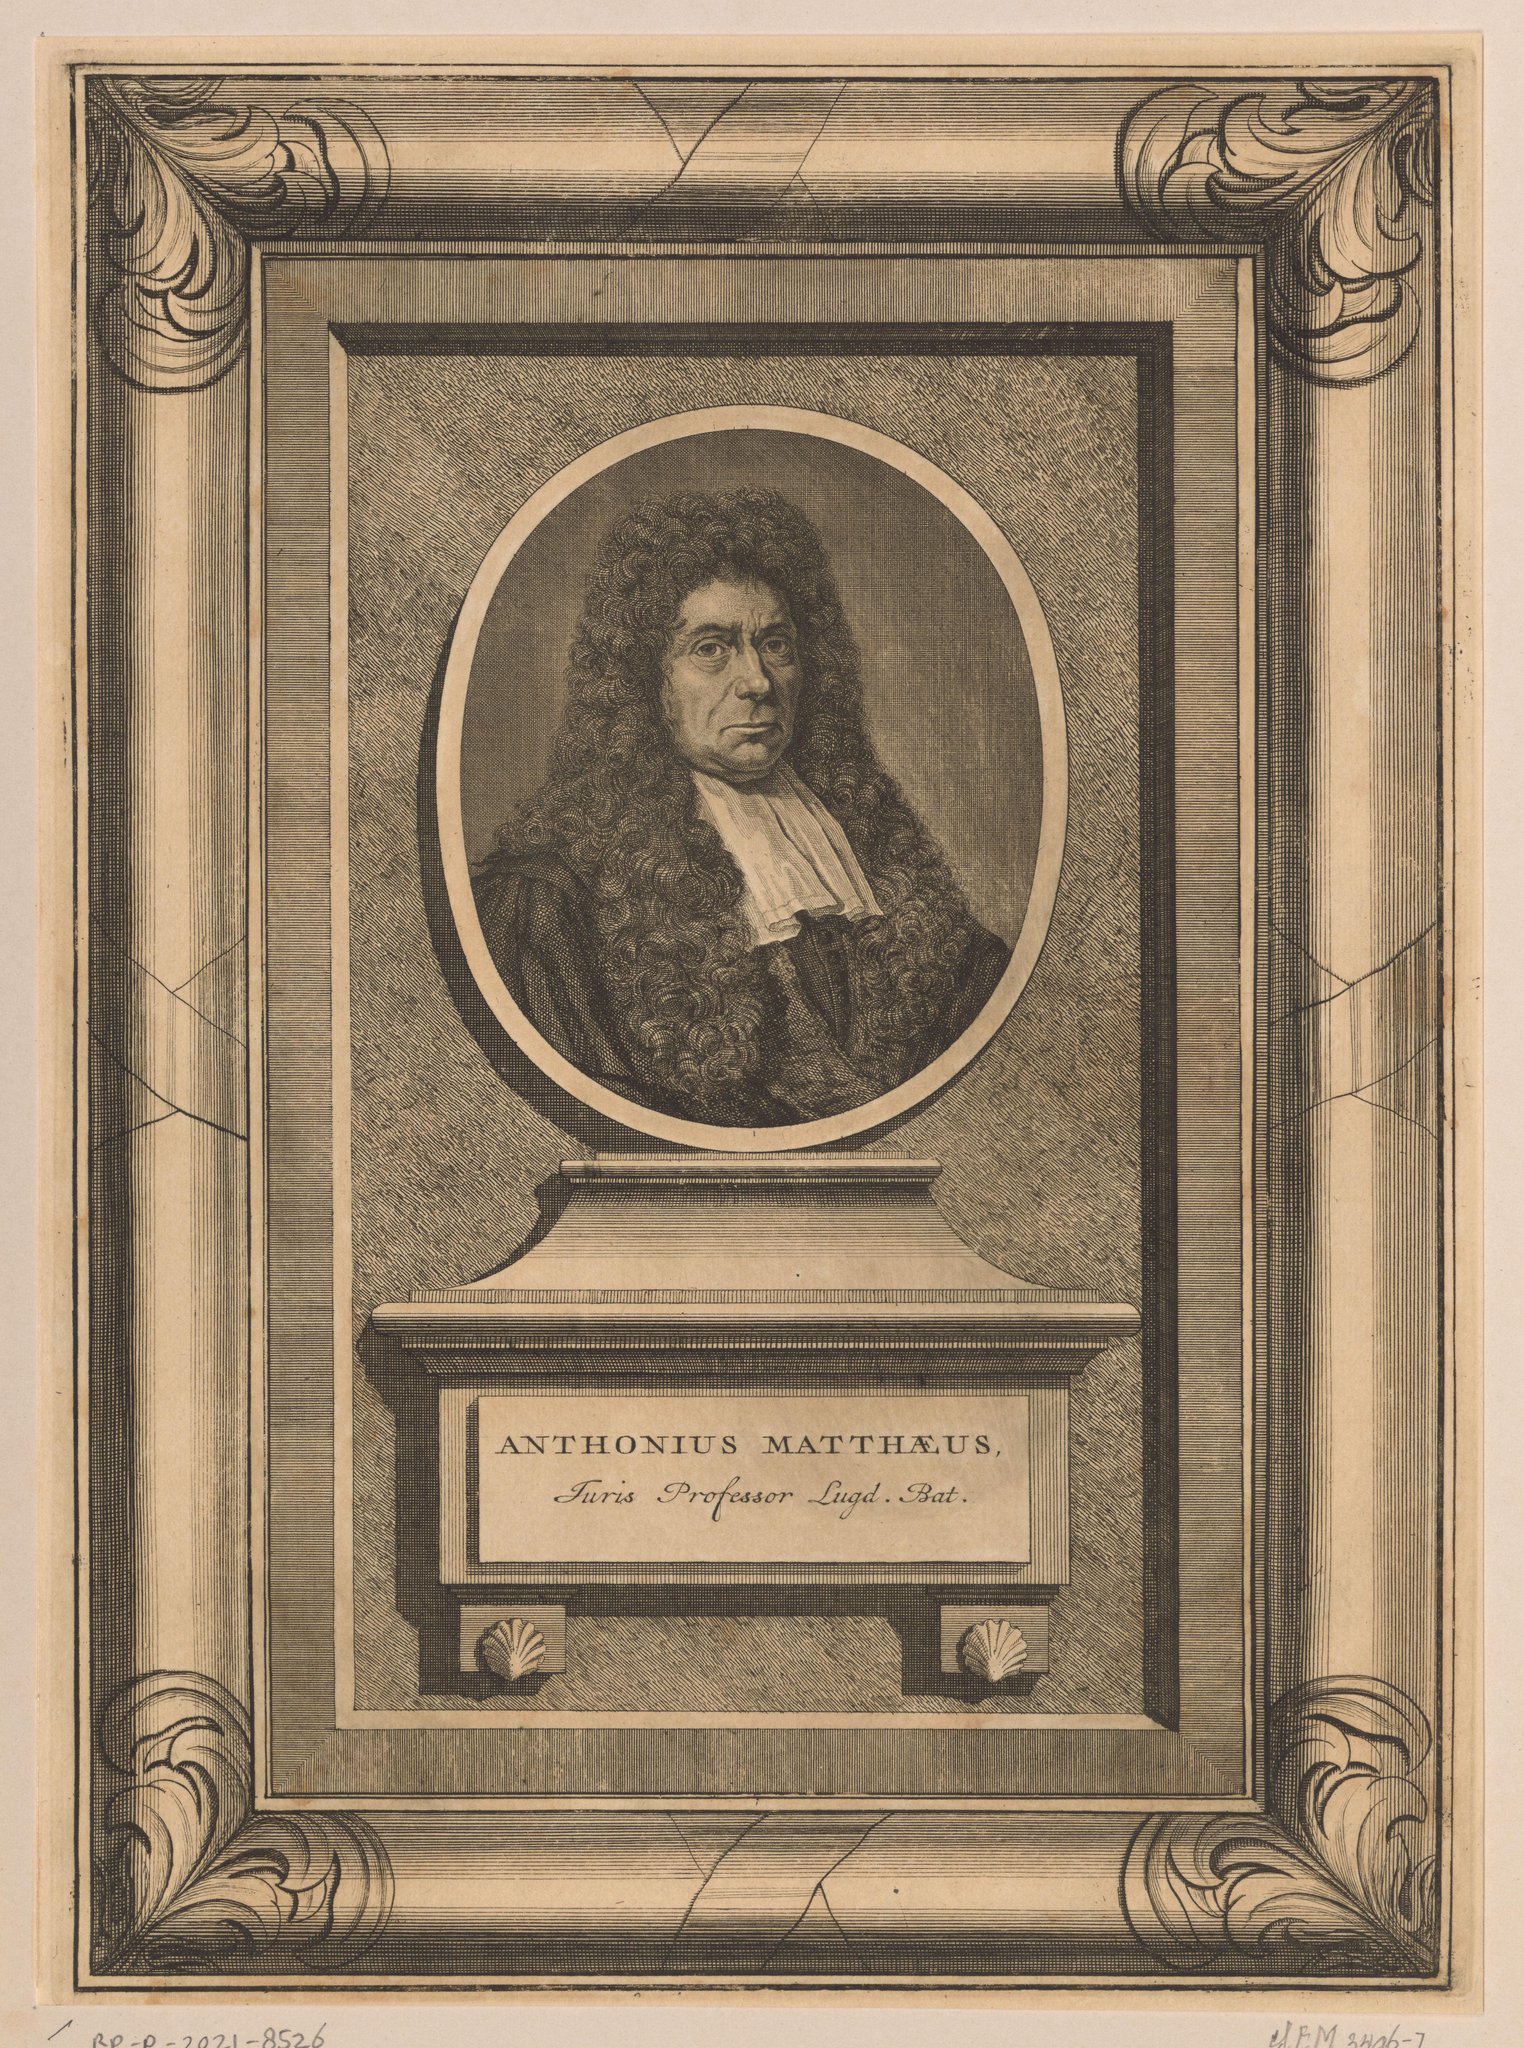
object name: print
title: Beroemde mannen aan de universiteit van Leiden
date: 1716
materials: paper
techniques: engraving, etching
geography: leiden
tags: utrecht, leiden, ornament ~ medallion, historical persons, professor